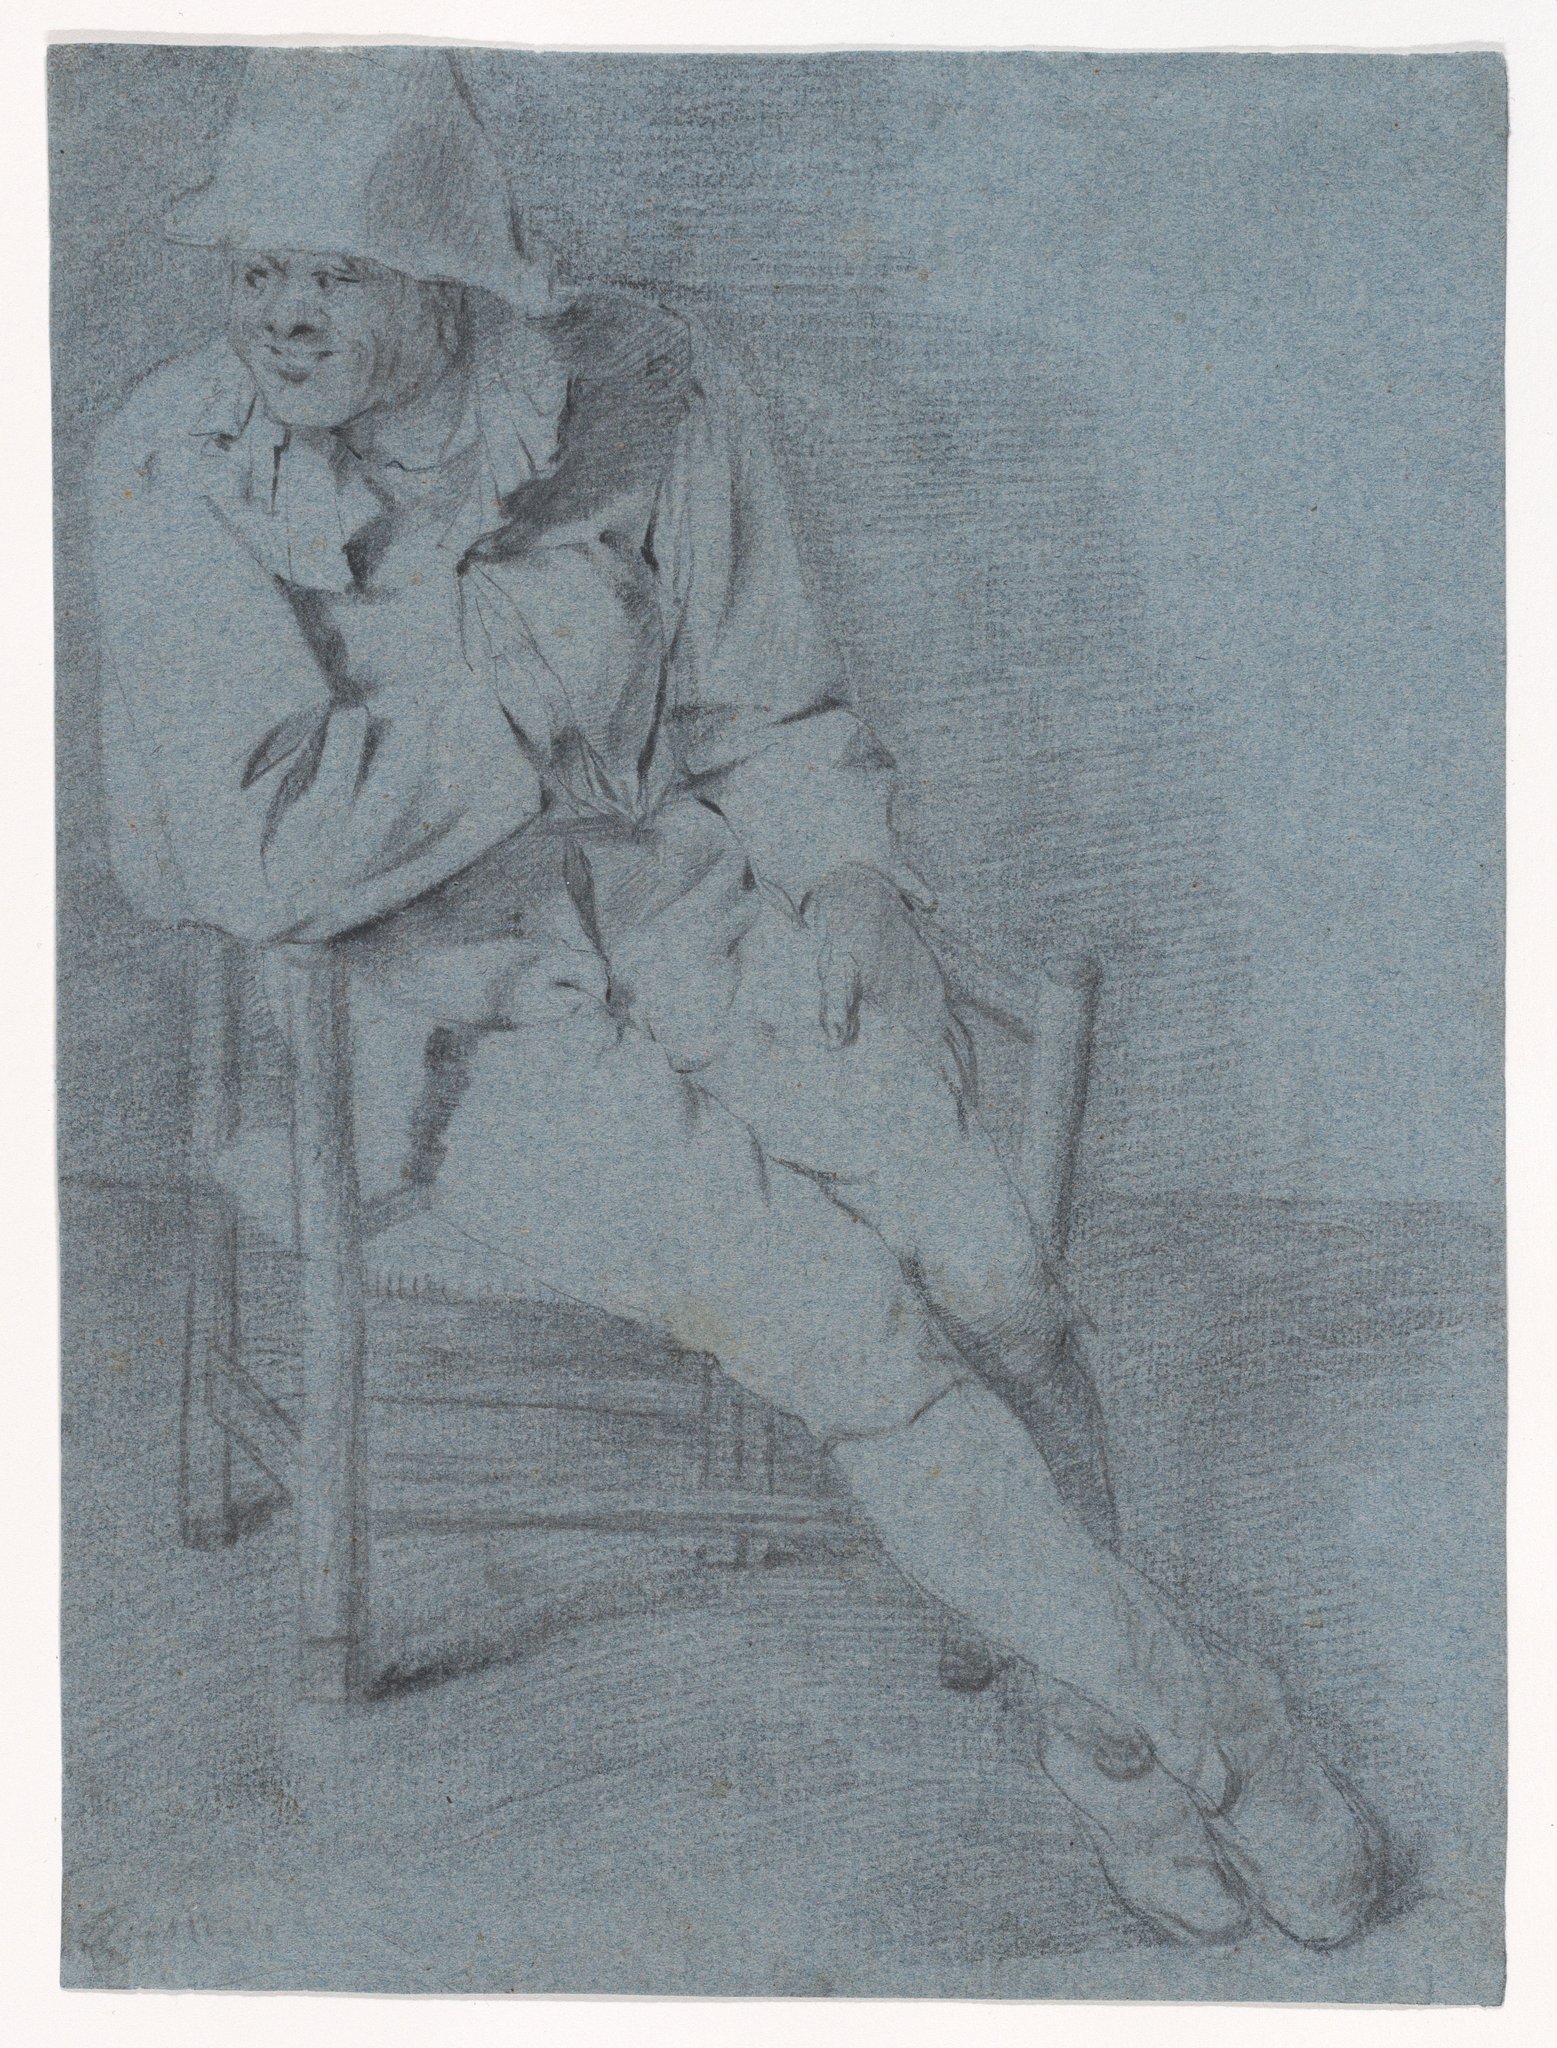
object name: drawing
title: Study of a seated man, one hand resting inside his jacket (recto); Unfinished study on a seated man (verso)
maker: cornelis bega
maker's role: artist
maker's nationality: dutch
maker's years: 1631-1664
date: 1634-1666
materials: chalk, paper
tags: men